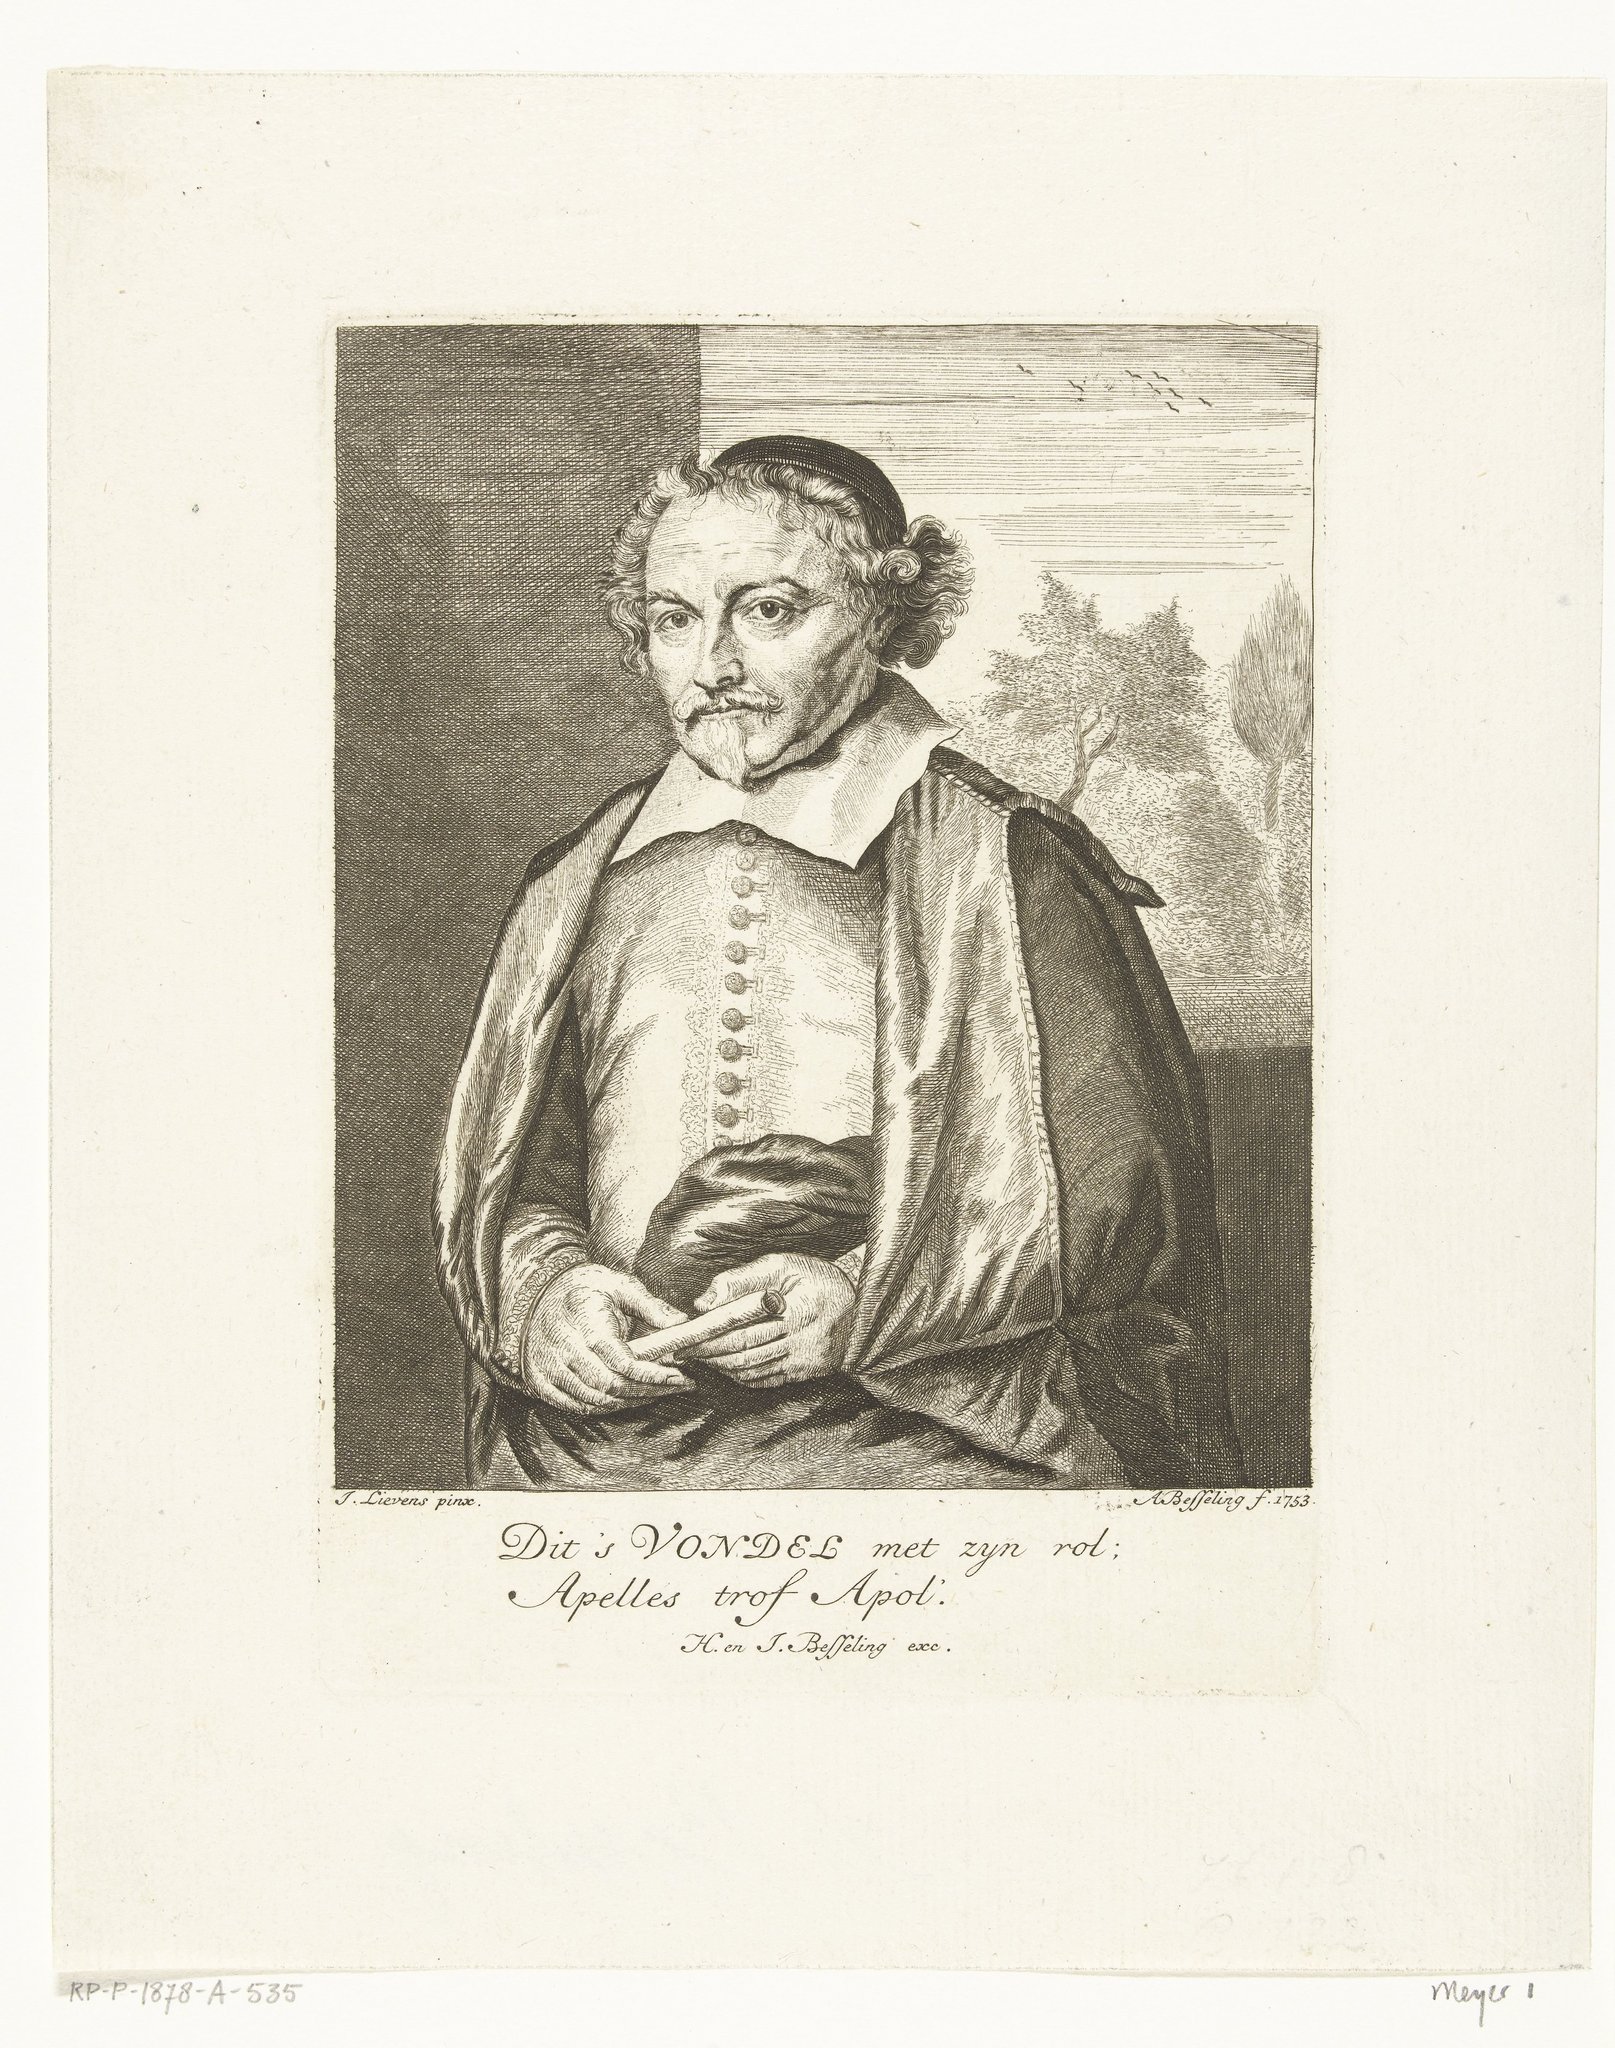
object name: print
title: Dit 's Vondel met zijn rol; Apelles trof Apol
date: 1753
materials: paper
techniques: engraving, etching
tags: cologne, amsterdam, joost van den vondel, portrait of a writer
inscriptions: collector's mark: Lugt 2228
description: Portret van Joost van den Vondel met rol papier in zijn hand, mogelijk een verwijzing naar zijn geschriften.